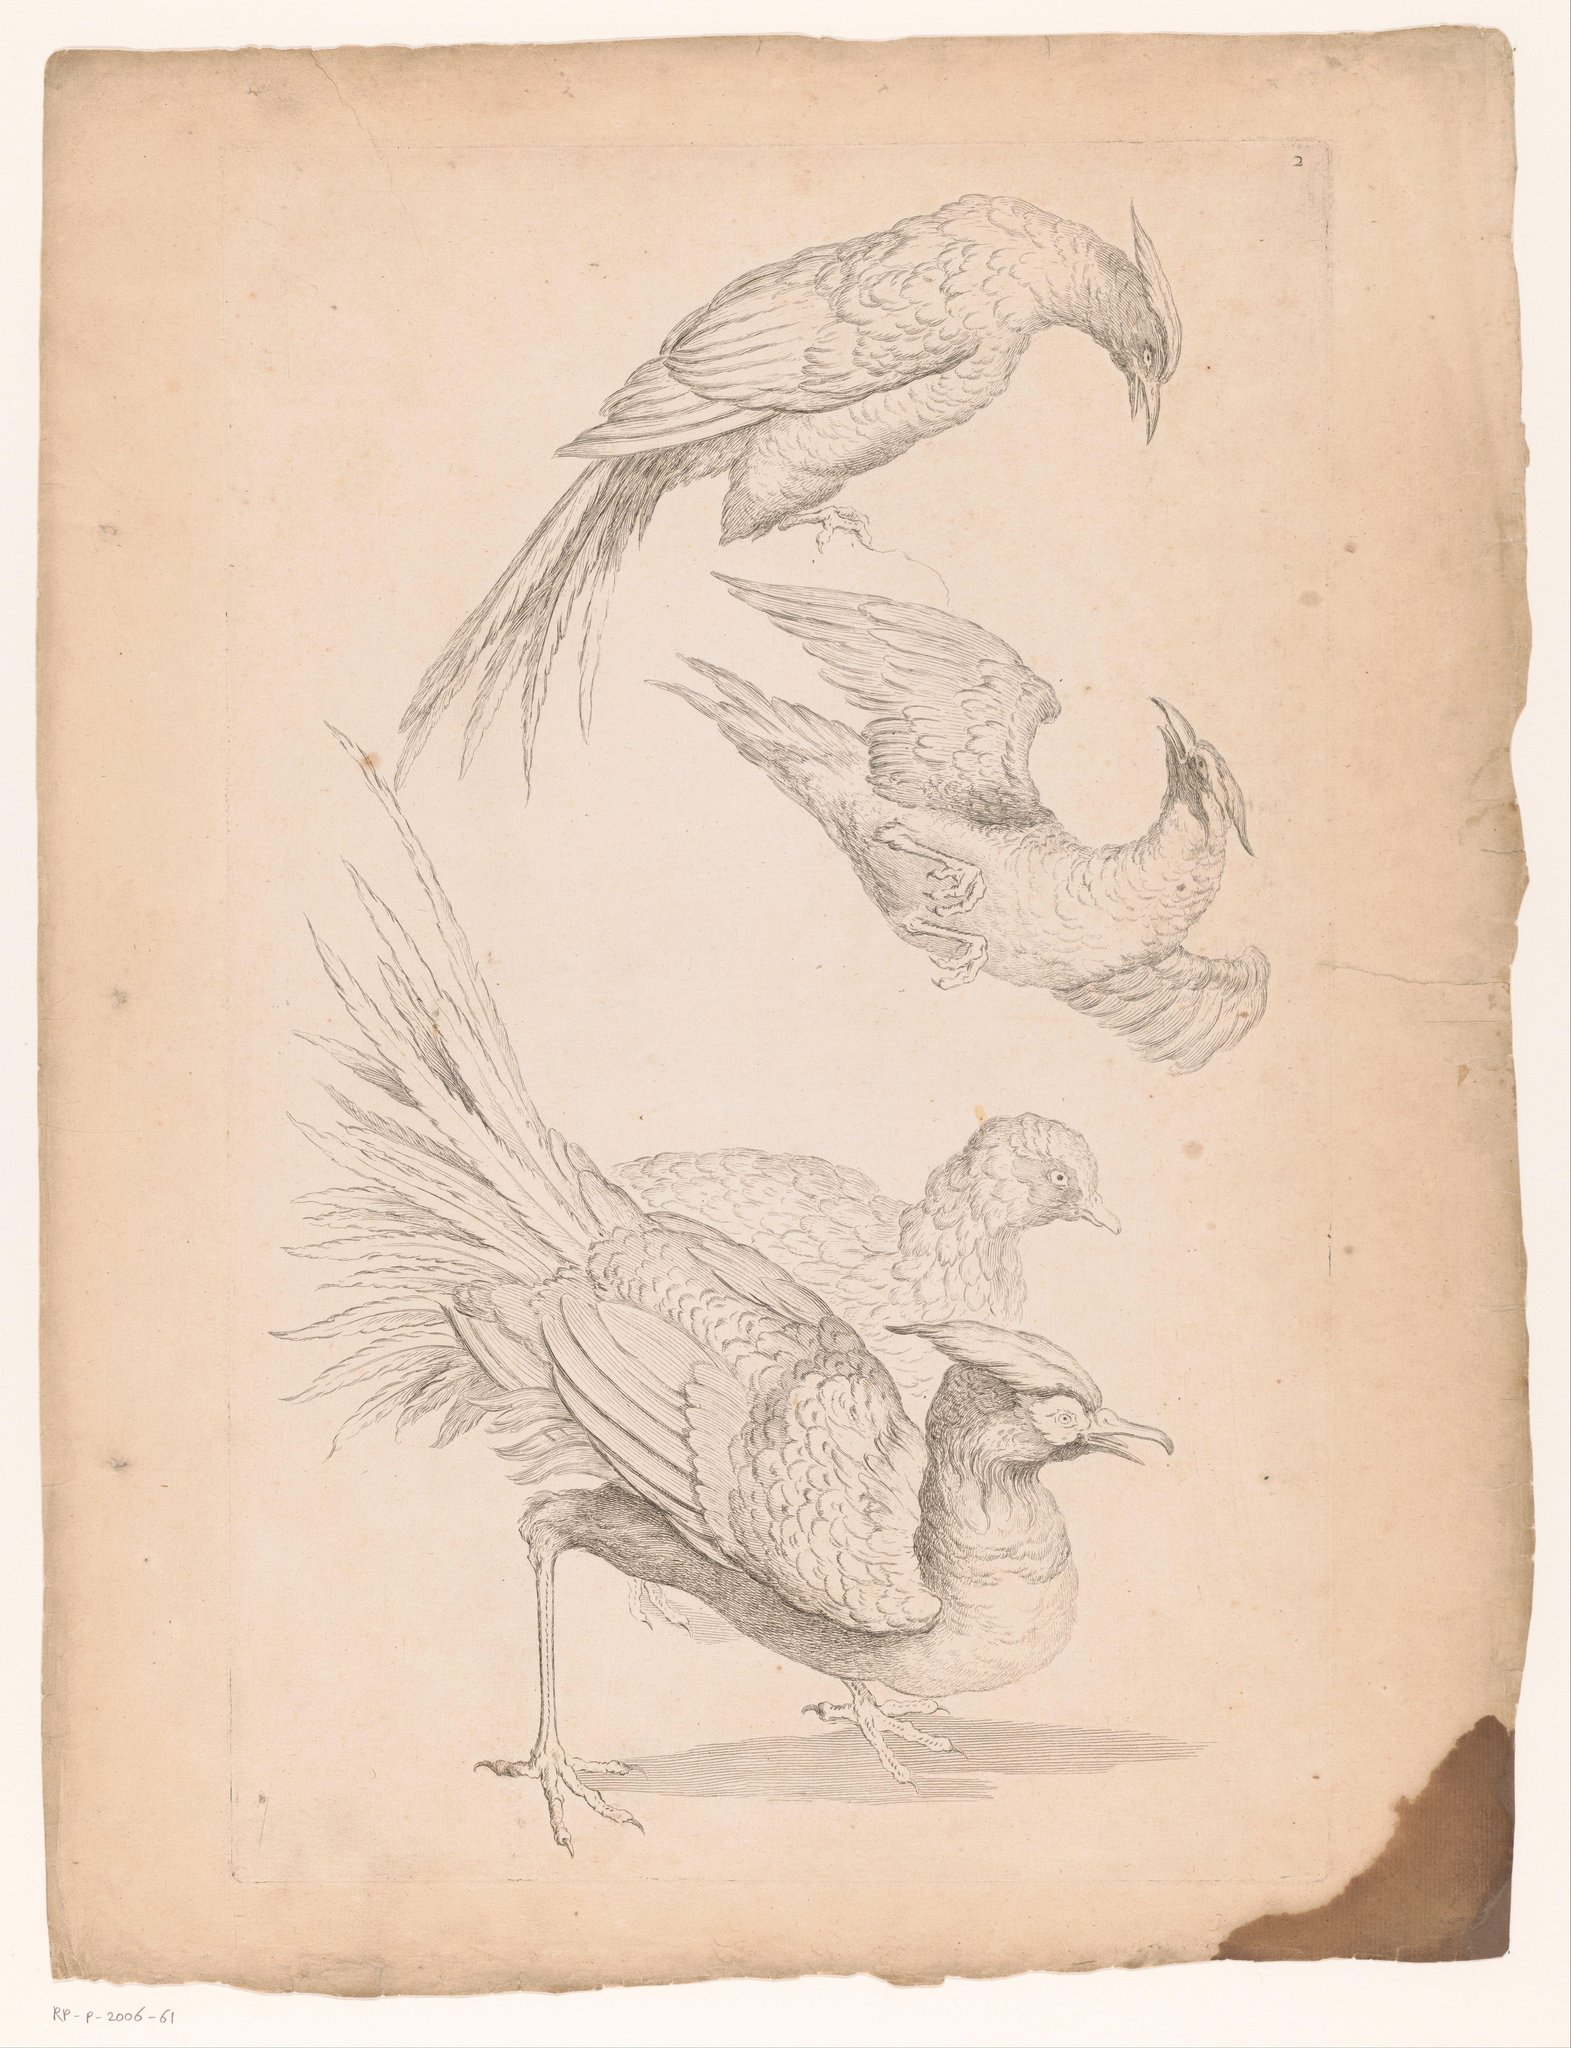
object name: ornament print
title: Livre des differentes éspeces d'oiseaux de la Chine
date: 1742-1750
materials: paper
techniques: etching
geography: france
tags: birds, ornamental birds: bird of paradise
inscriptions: collector's mark: Lugt 2760, collector's mark: Lugt 2228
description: Maakt deel uit van een vijftiendelige serie met prenten van vogels uit China.